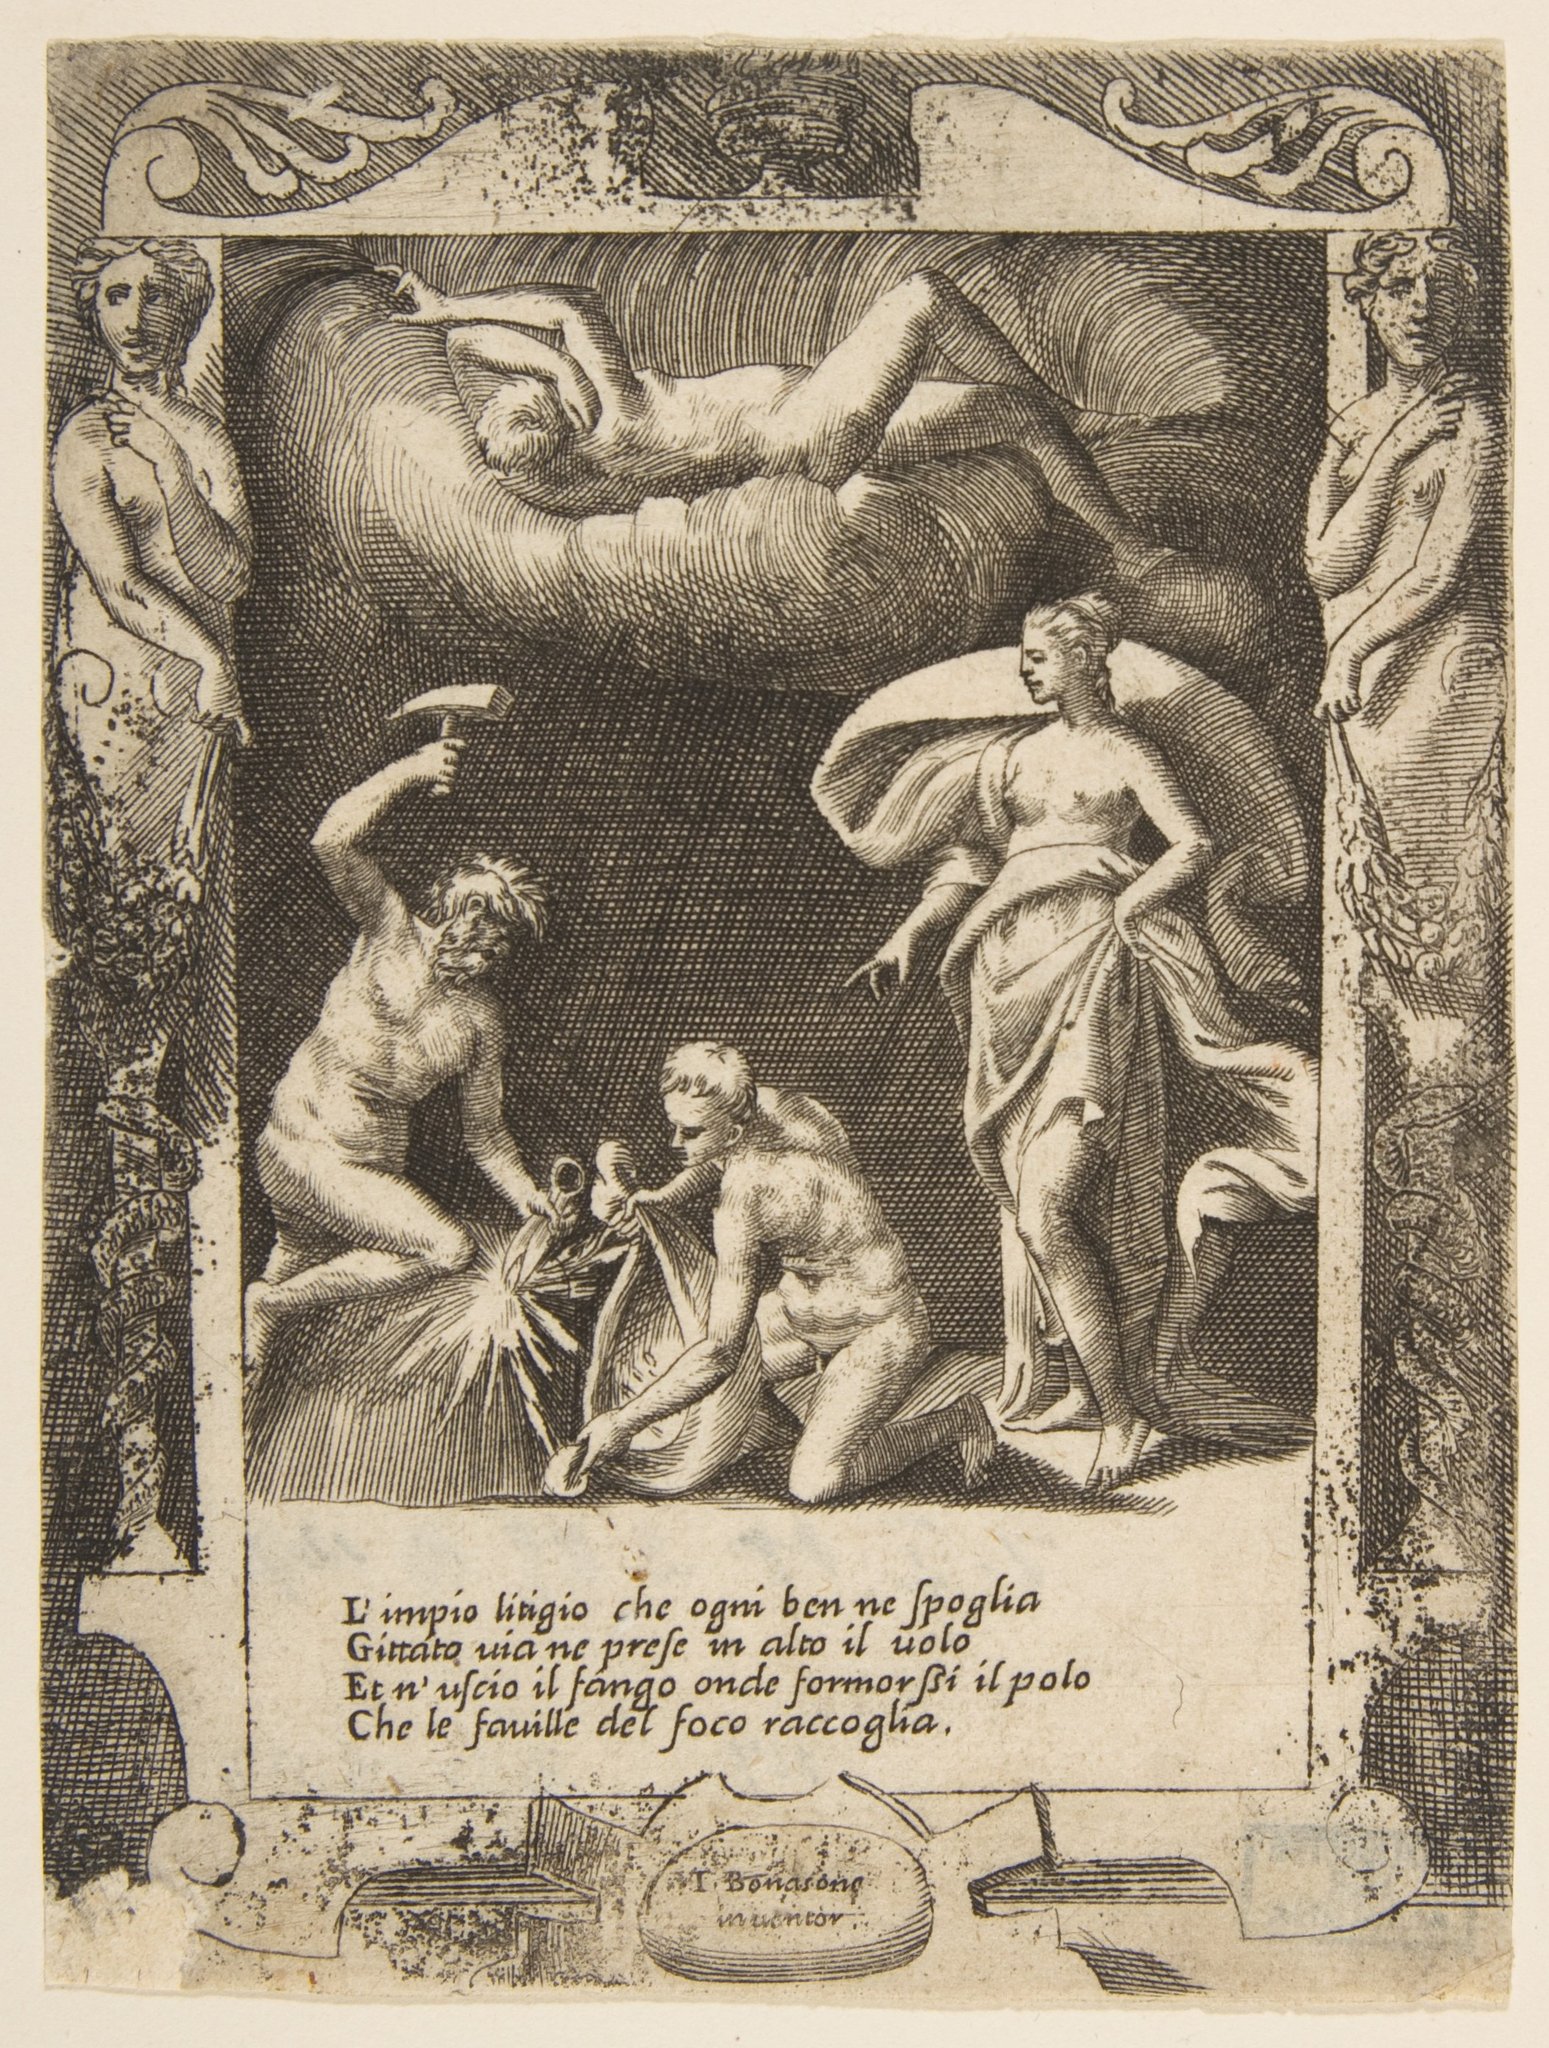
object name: print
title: Litigium removed from the body of Chaos while his mother is thrown into the air, set within a frame, from "Loves, Rages and Jealousies of Juno"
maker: giulio bonasone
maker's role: artist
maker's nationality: italian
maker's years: 1510-1576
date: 1531-1576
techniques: engraving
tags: male nudes,mothers,female nudes,working